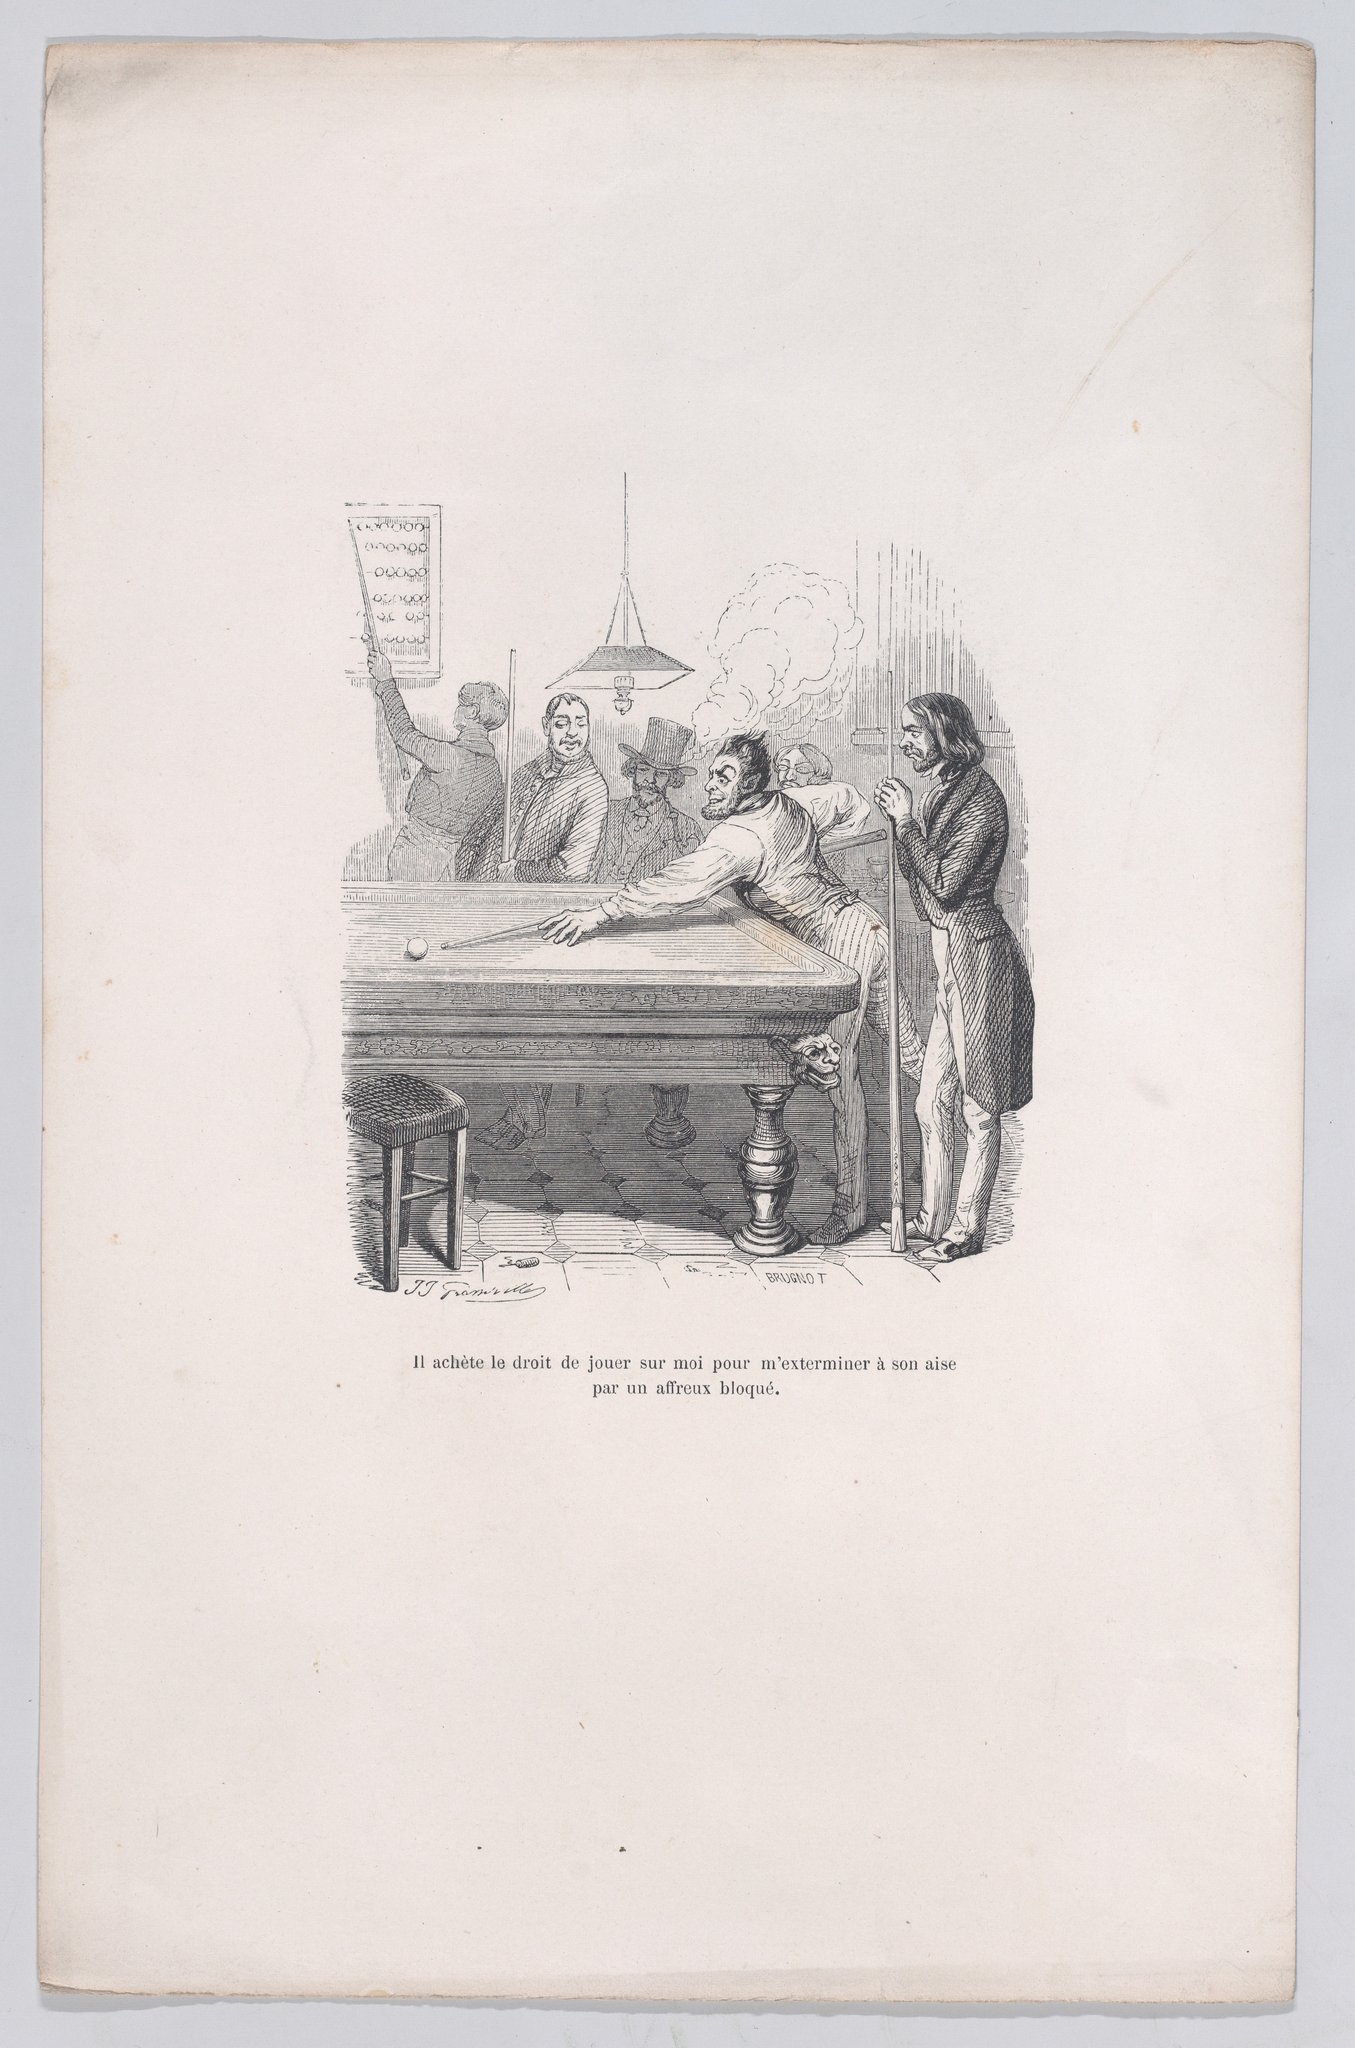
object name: print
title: He buys the right to defeat me at his ease with a successful shot, from "Little Miseries of Human Life"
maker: j. j. grandville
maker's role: illustrator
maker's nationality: french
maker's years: 1803-1847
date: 1843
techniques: engraving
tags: men,billiards